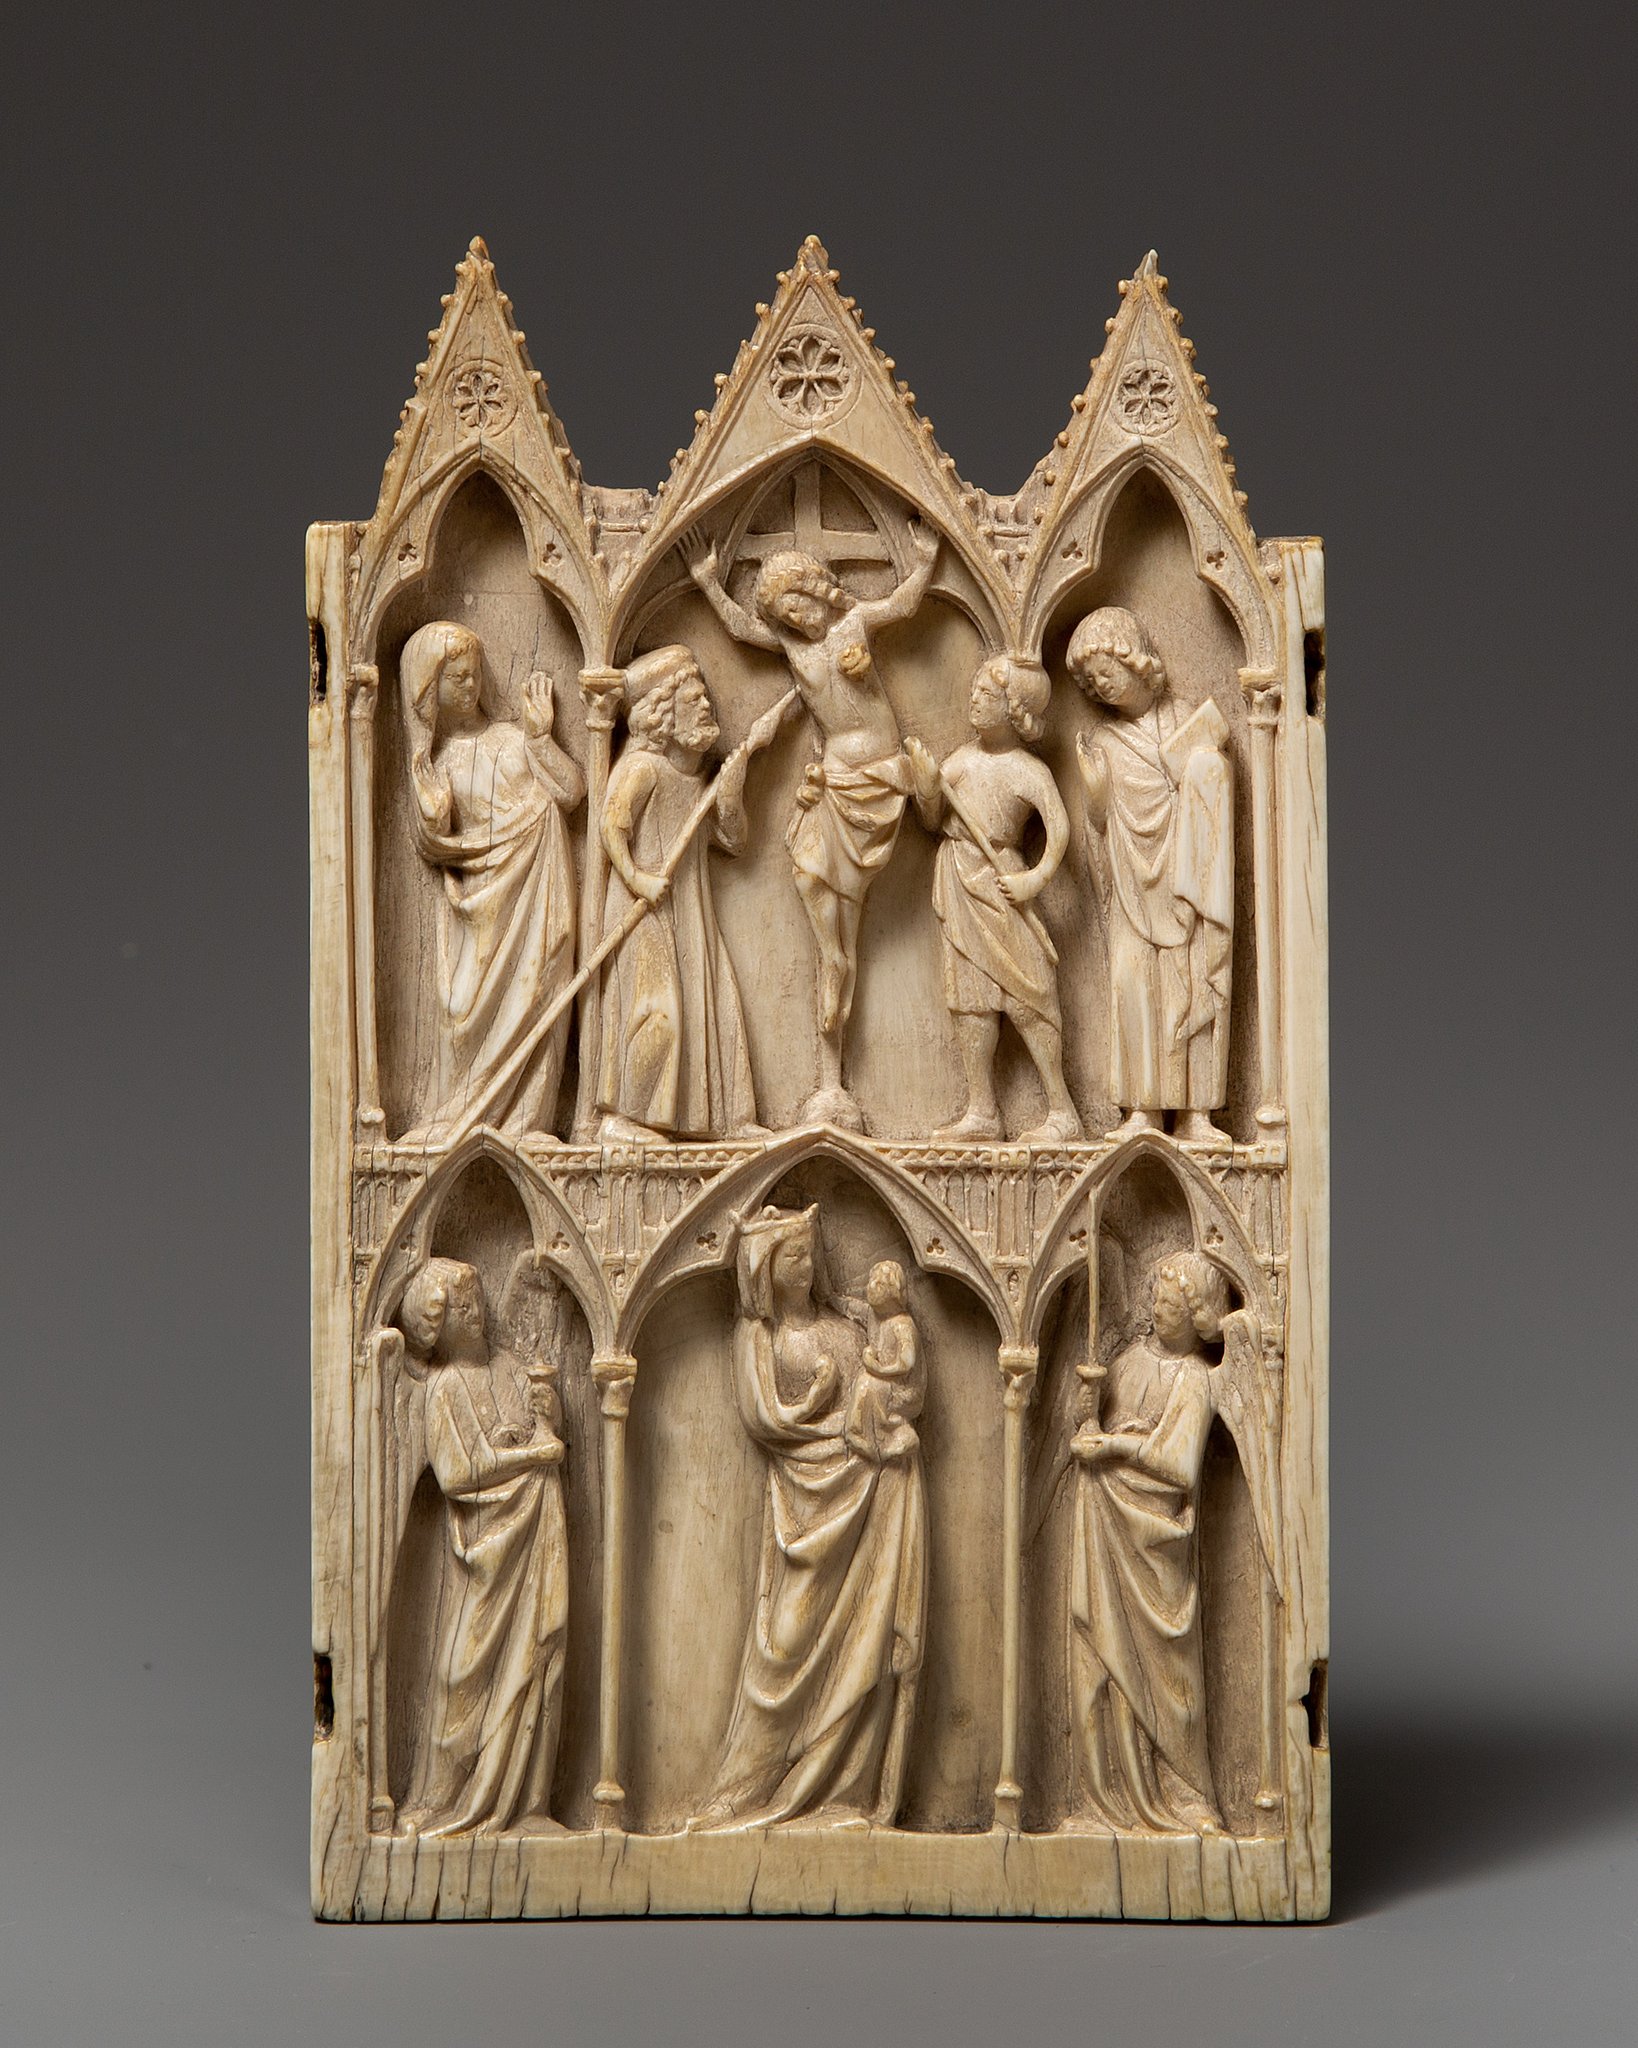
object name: triptych center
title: Central Panel of a Triptych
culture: french, north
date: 1280-1290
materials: ivory, paint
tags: men,madonna and child,saint john the evangelist,crucifixion